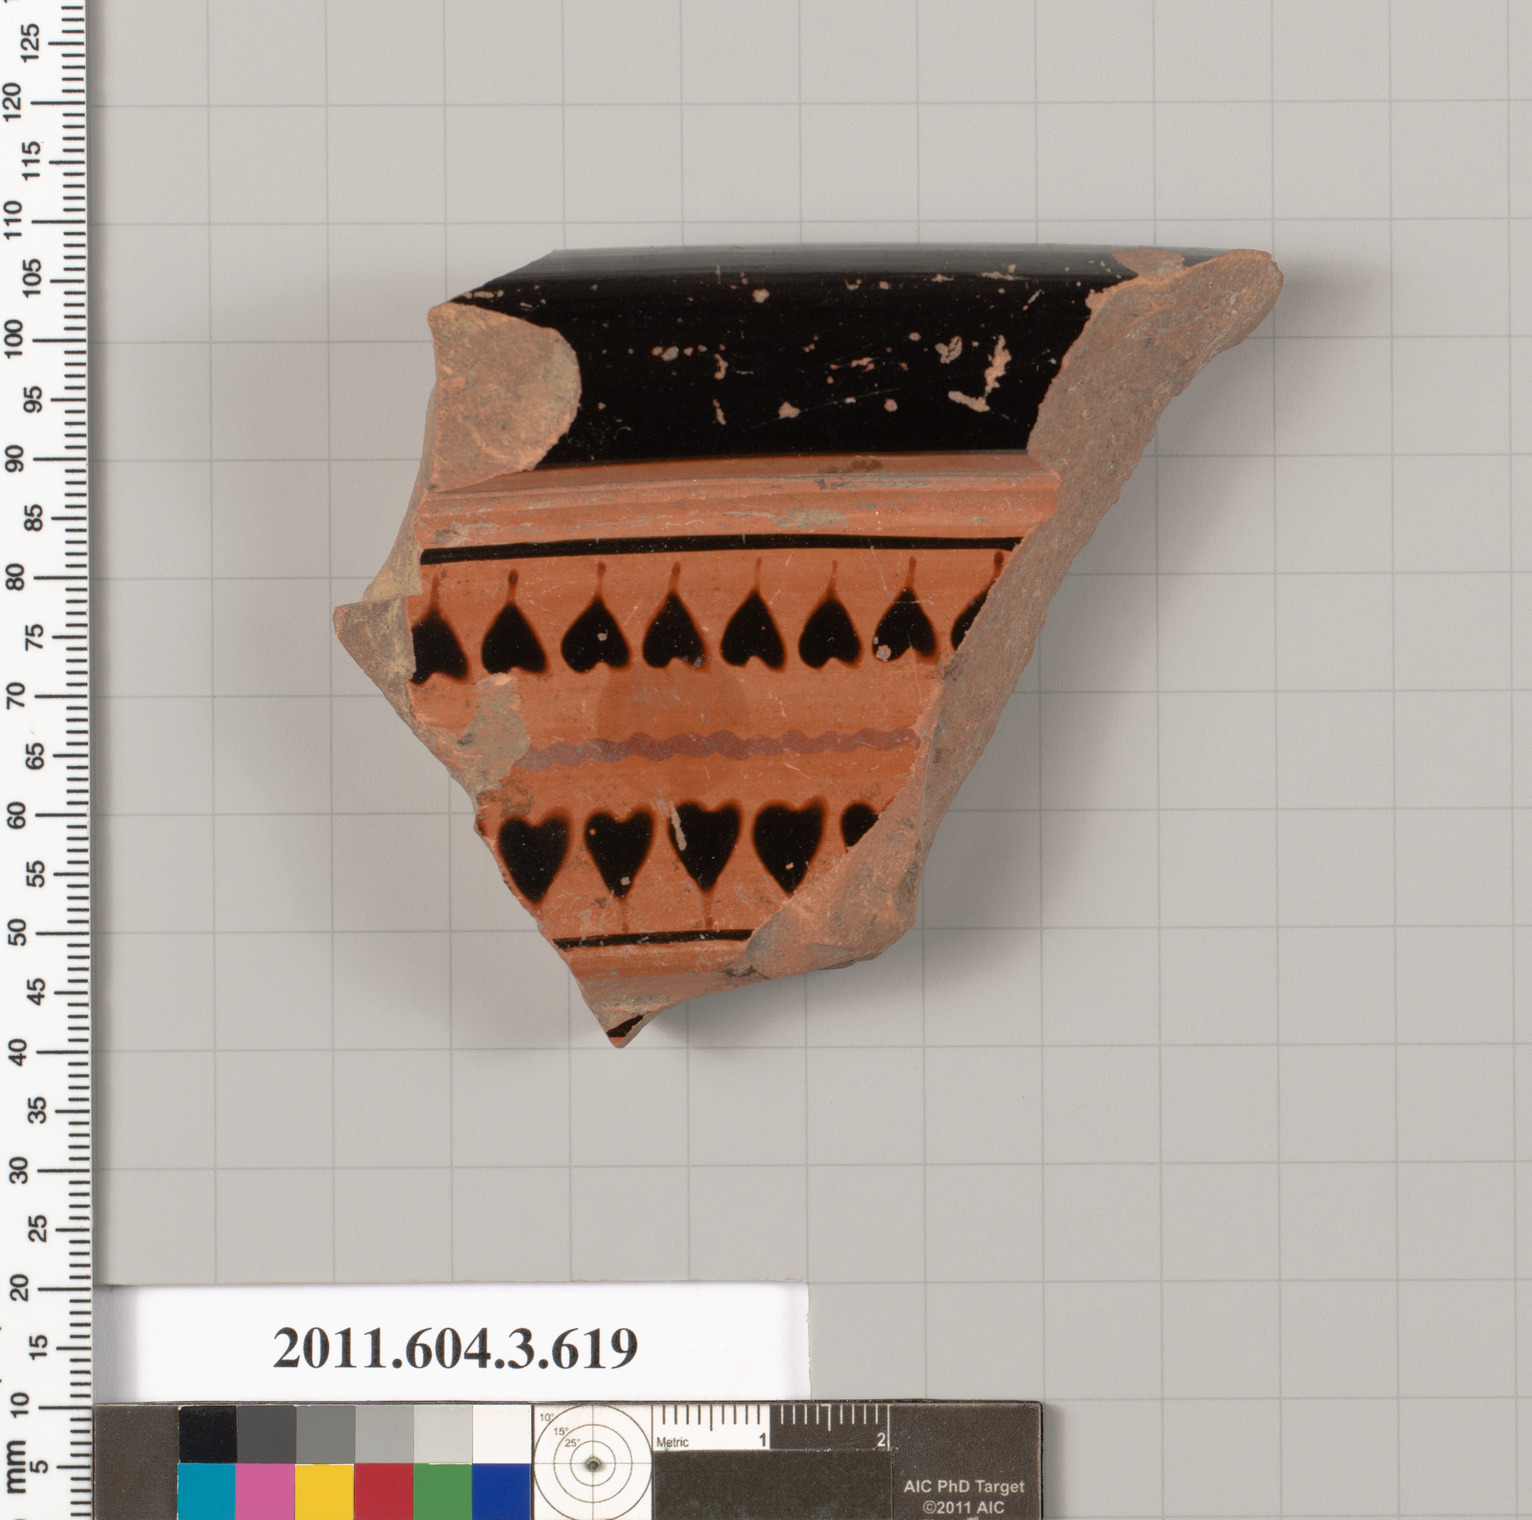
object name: calyx krater fragment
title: Terracotta fragment of a calyx-krater (bowl for mixing wine and water)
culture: greek, attic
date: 540-530 BCE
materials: terracotta